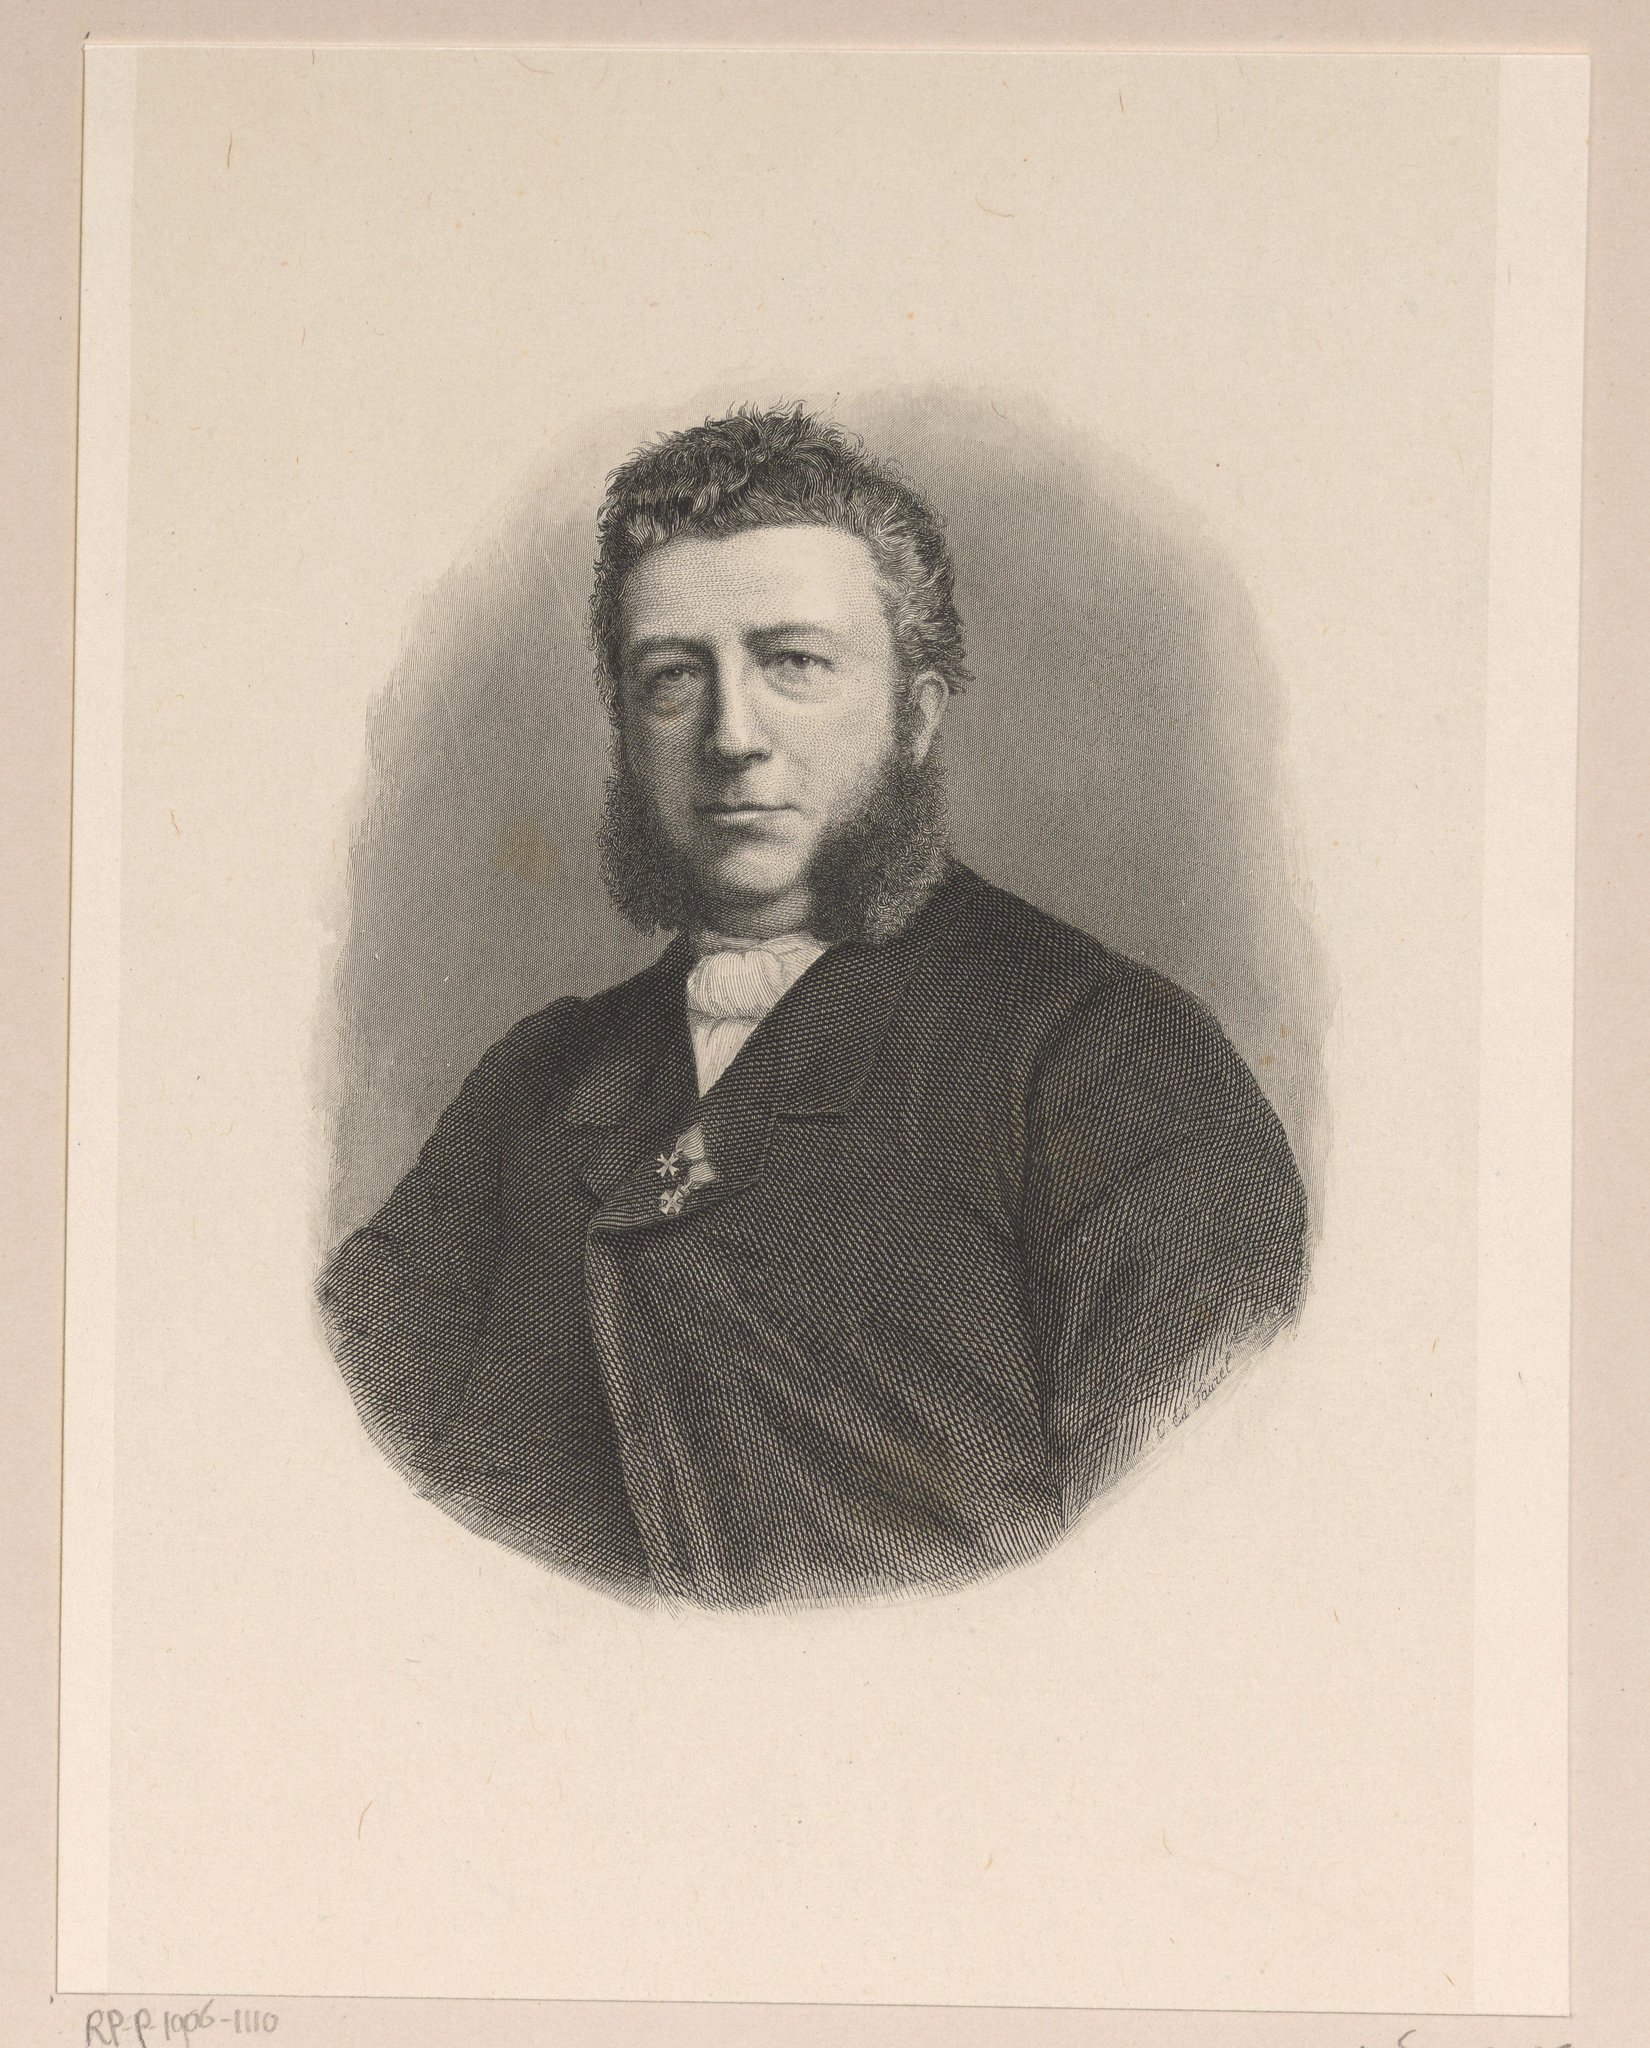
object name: print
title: Portret van Jan Jacob Lodewijk ten Kate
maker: edouard taurel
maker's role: draughtsman, print maker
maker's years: 1824-1892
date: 1866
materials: paper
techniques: engraving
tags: the hague, amsterdam, jan jakob lodewijk ten kate, historical persons, writer, poet, author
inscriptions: collector's mark: Lugt 2228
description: Prent mogelijk uit: Kate, Jan Jacob Lodewijk ten. De schepping. Utrecht: Kemink & Zoon, 1866.